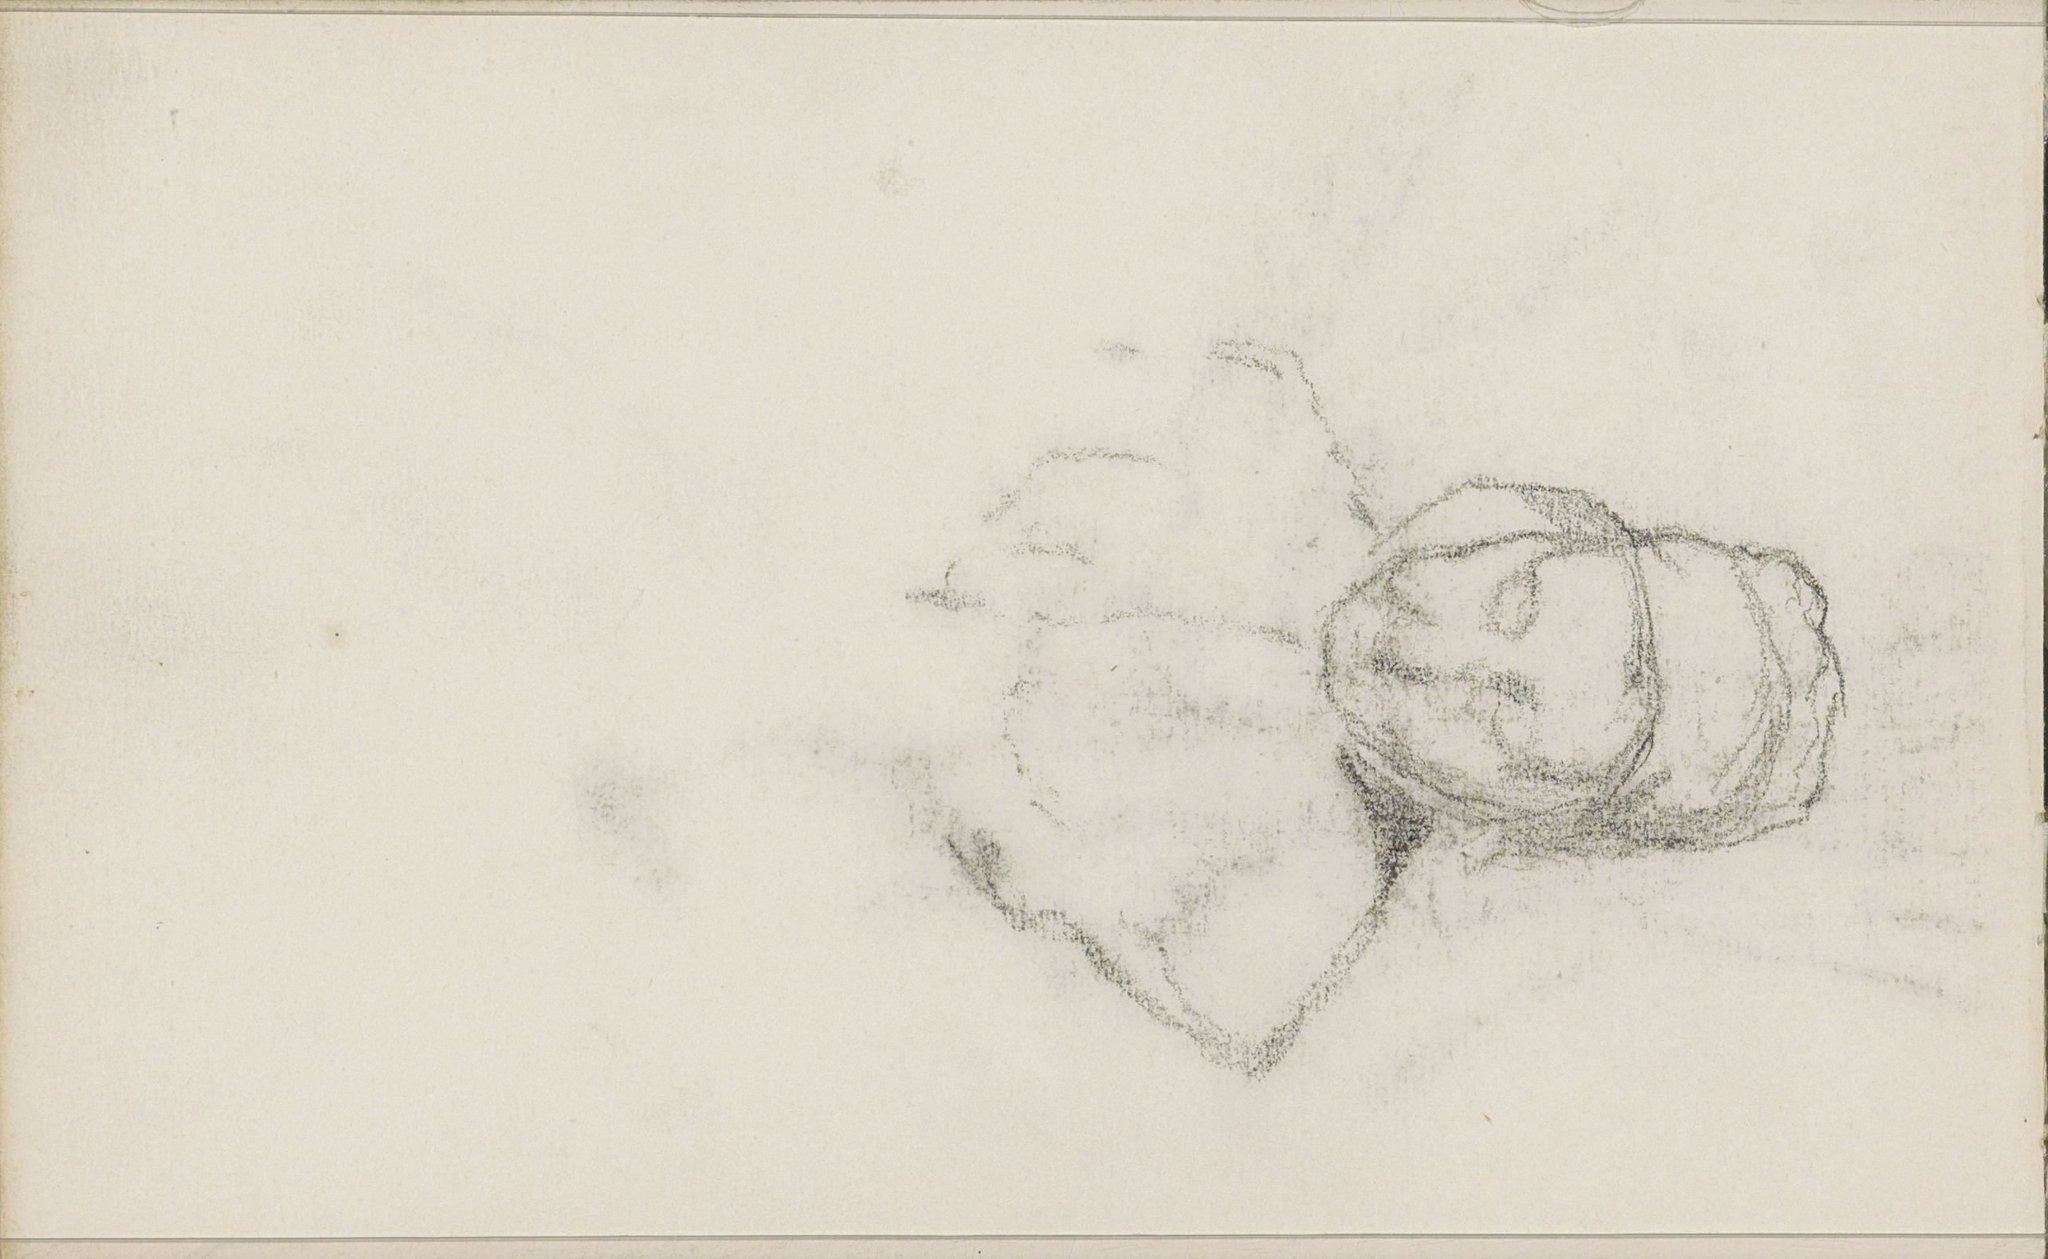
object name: sketchbook leaf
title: Kop van een oudere vrouw met een muts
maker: anton mauve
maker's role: draughtsman, painter, print maker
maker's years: 1838-1888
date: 1848-1888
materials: chalk, paper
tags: head (human) - aa - female human figure (+ old female (human being))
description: Blad 34 verso uit een schetsboek met 41 bladen.